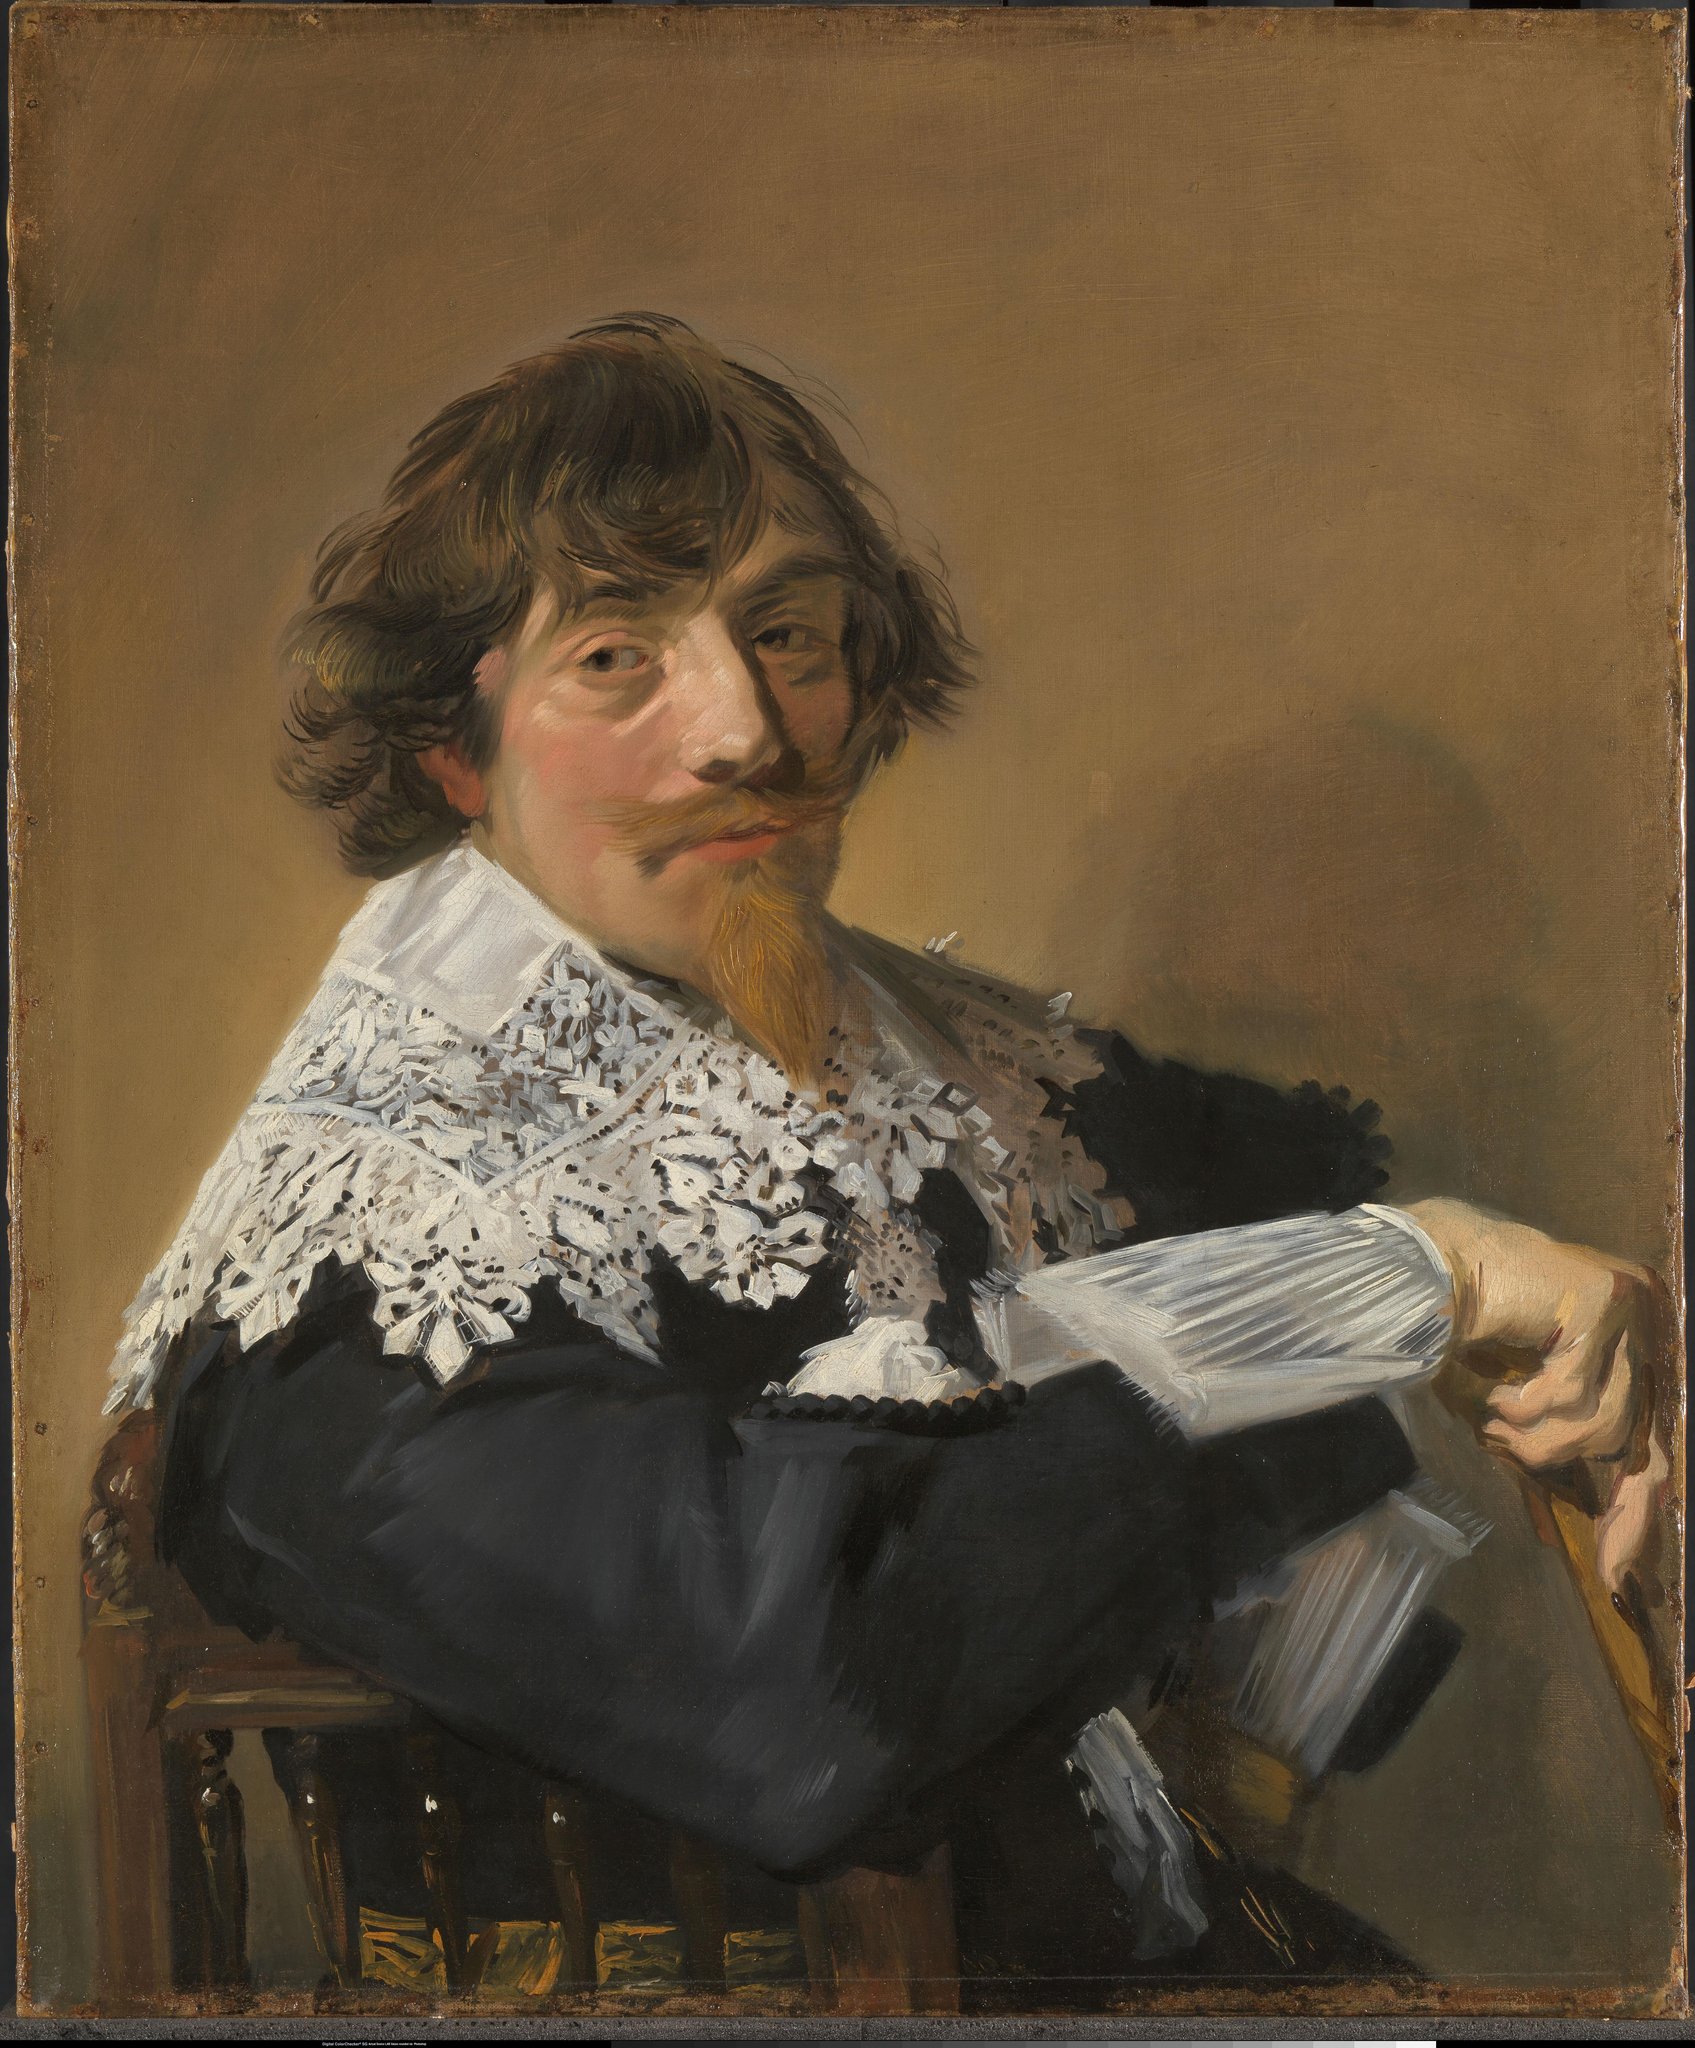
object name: painting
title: Portrait of Jan van de Poll (1597-1678)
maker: frans hals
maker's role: draughtsman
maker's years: 1582-1666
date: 1637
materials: canvas, oil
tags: historical persons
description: Jan van de Poll (1597-1678) en Duifje van Gerwen (1618-1658) trouwden in 1637. Duifje was de jongste dochter van een rijke Amsterdamse wijnhandelaar aan de Warmoesstraat. Jan werd zeven keer burgemeester van Amsterdam en klom in 1650 op tot de hoogste rang van de Amsterdamse schutterij, die van kolonel. In die hoedanigheid werd hij in dat jaar en in het jaar 1653 geportretteerd door respectievelijk Johann Spilberg en Bartholomeus van der Helst, beiden in de collectie van het Amsterdam Museum. Zijn gezicht op de deze werken is goed te vergelijken met dat in het portret van Frans Hals, dat kort na het huwelijk met Duifje zal zijn vervaardigd. Het zijn de enige huwelijkspendanten van een Amsterdams stel dat Frans Hals heeft vervaardigd. Jan en Duifje reisden er rond 1637 speciaal voor naar Haarlem. De aanbeveling om de Haarlemmer Frans Hals de huwelijkspendanten (bij elkaar behorende werken) te laten schilderen zal van Duifjes oom Willem Warmond zijn gekomen. Warmond figureert zelf als kapitein in het Haarlems schuttersstuk van Hals van tien jaar eerder. In 1633 begon Hals aan zijn enige groepsportret met Amsterdamse schutters, de ‘Magere compagnie’. Enkele schutters waren niet bereid om naar Haarlem af te reizen om door Hals te worden geportretteerd. Vandaar dat het schilderij 1637 is afgemaakt door de Amsterdamse schilder Pieter Codde. Jan en Duifje hebben kennelijk van dat gat in Hals’ agenda geprofiteerd. Zij waren wel bereid om naar Haarlem te gaan. De portretten van Jan van de Poll en Duifje van Gerwen zijn de enige pendanten van een Amsterdams stel dat Frans Hals heeft vervaardigd. Toen de twee portretten in 1885 het Rijksmuseum binnenkwamen als onderdeel van een legaat, koppelde directeur Frederik Obreen de namen Nicolaes Hasselaer (1593-1635) en Sara Wolphaerts van Diemen (1594-1667) aan de portretten. Rijksmuseumconservator 17de-eeuwse Nederlandse schilderkunst Jonathan Bikker heeft onlangs kunnen vaststellen dat de eerdere identificatie van de geportretteerden niet klopte. Testamenten van de klein- en achterkleinkinderen van Hasselaer en Van Diemen tonen aan dat de portretten onmogelijk in de verervingslijn passen. Jonathan heeft het portret van Jan van de Poll vergeleken met bovengenoemde later geschilderde portretten. Van Duifje van Gerwen zijn geen andere portretten bekend. Jan en Duifje zijn directe voorouders van Jonkheer Jan Stanislaus Robert van de Poll, die de schilderijen in 1885 aan het Rijksmuseum schonk.